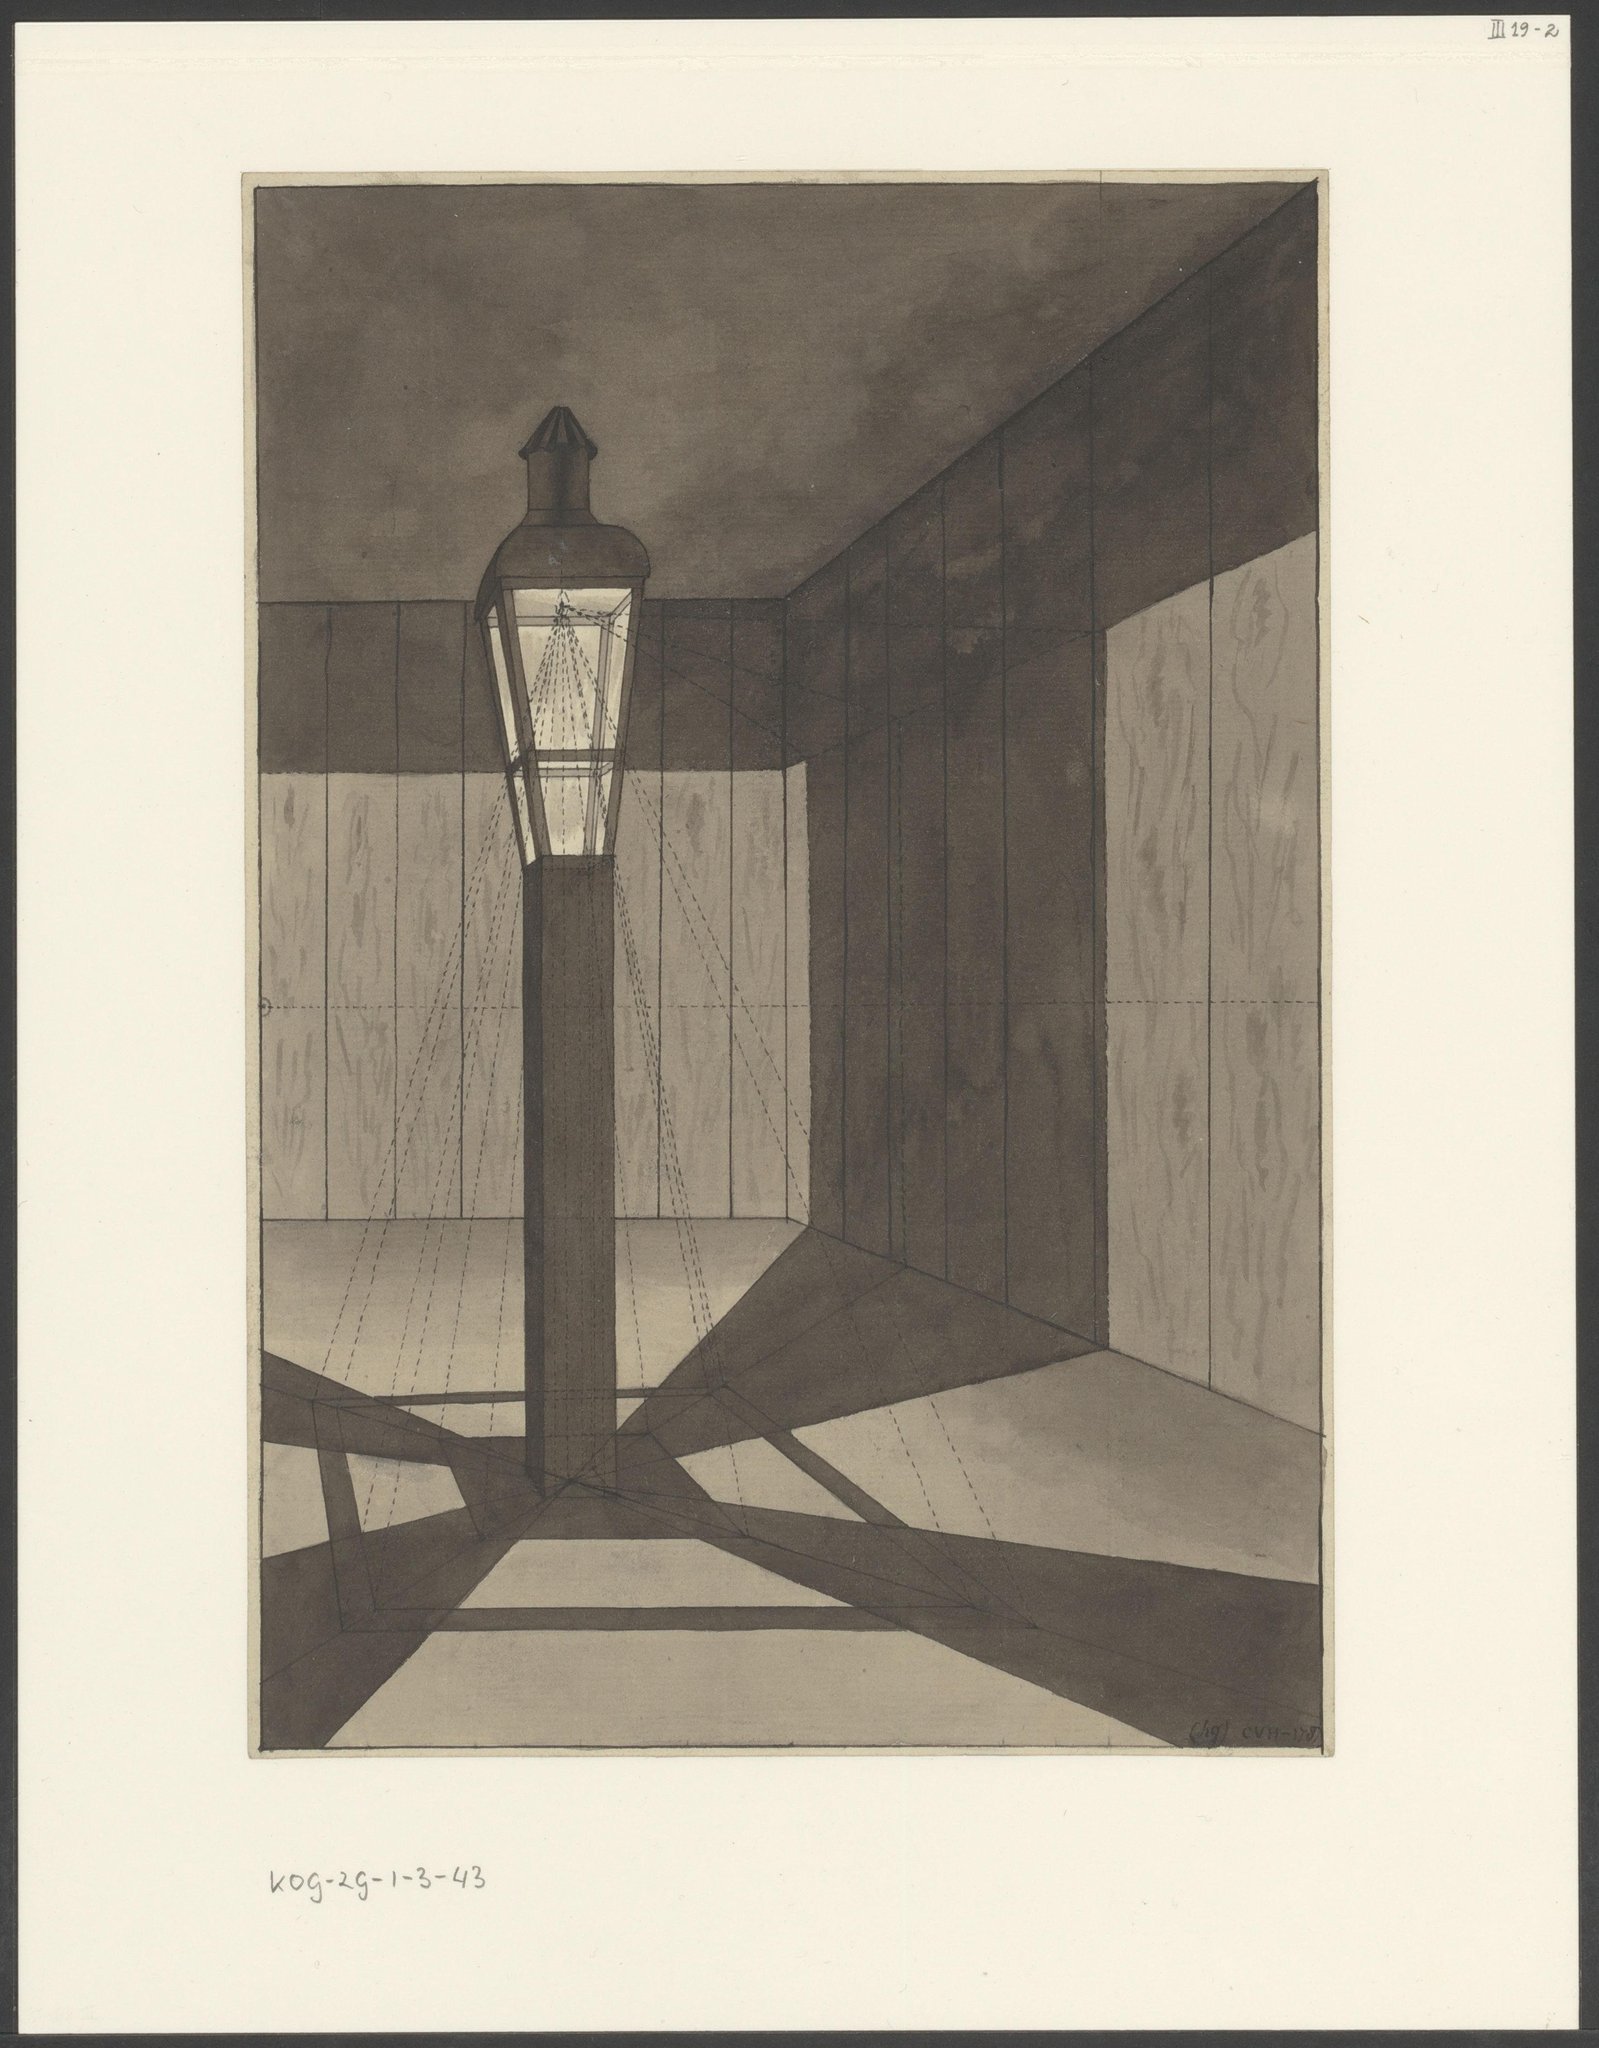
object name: drawing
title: Straatlantaarn met de projectie van het licht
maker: Anonymous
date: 1787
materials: ink, paper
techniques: brush, pen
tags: street lighting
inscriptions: signature: ‘(hg) CVH-1787’, watermark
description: Onderwerpsrubrieken binnen de Atlas Zeden en Gewoonten: Regeering, Straatverlichting.